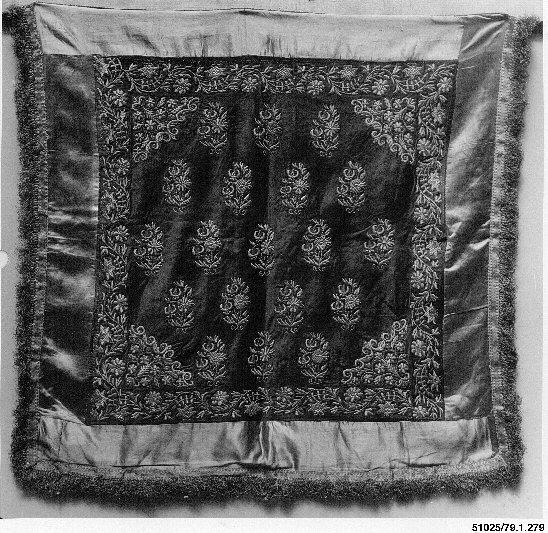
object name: cover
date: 1801-1833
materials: metal thread, silk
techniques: embroidery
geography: turkey